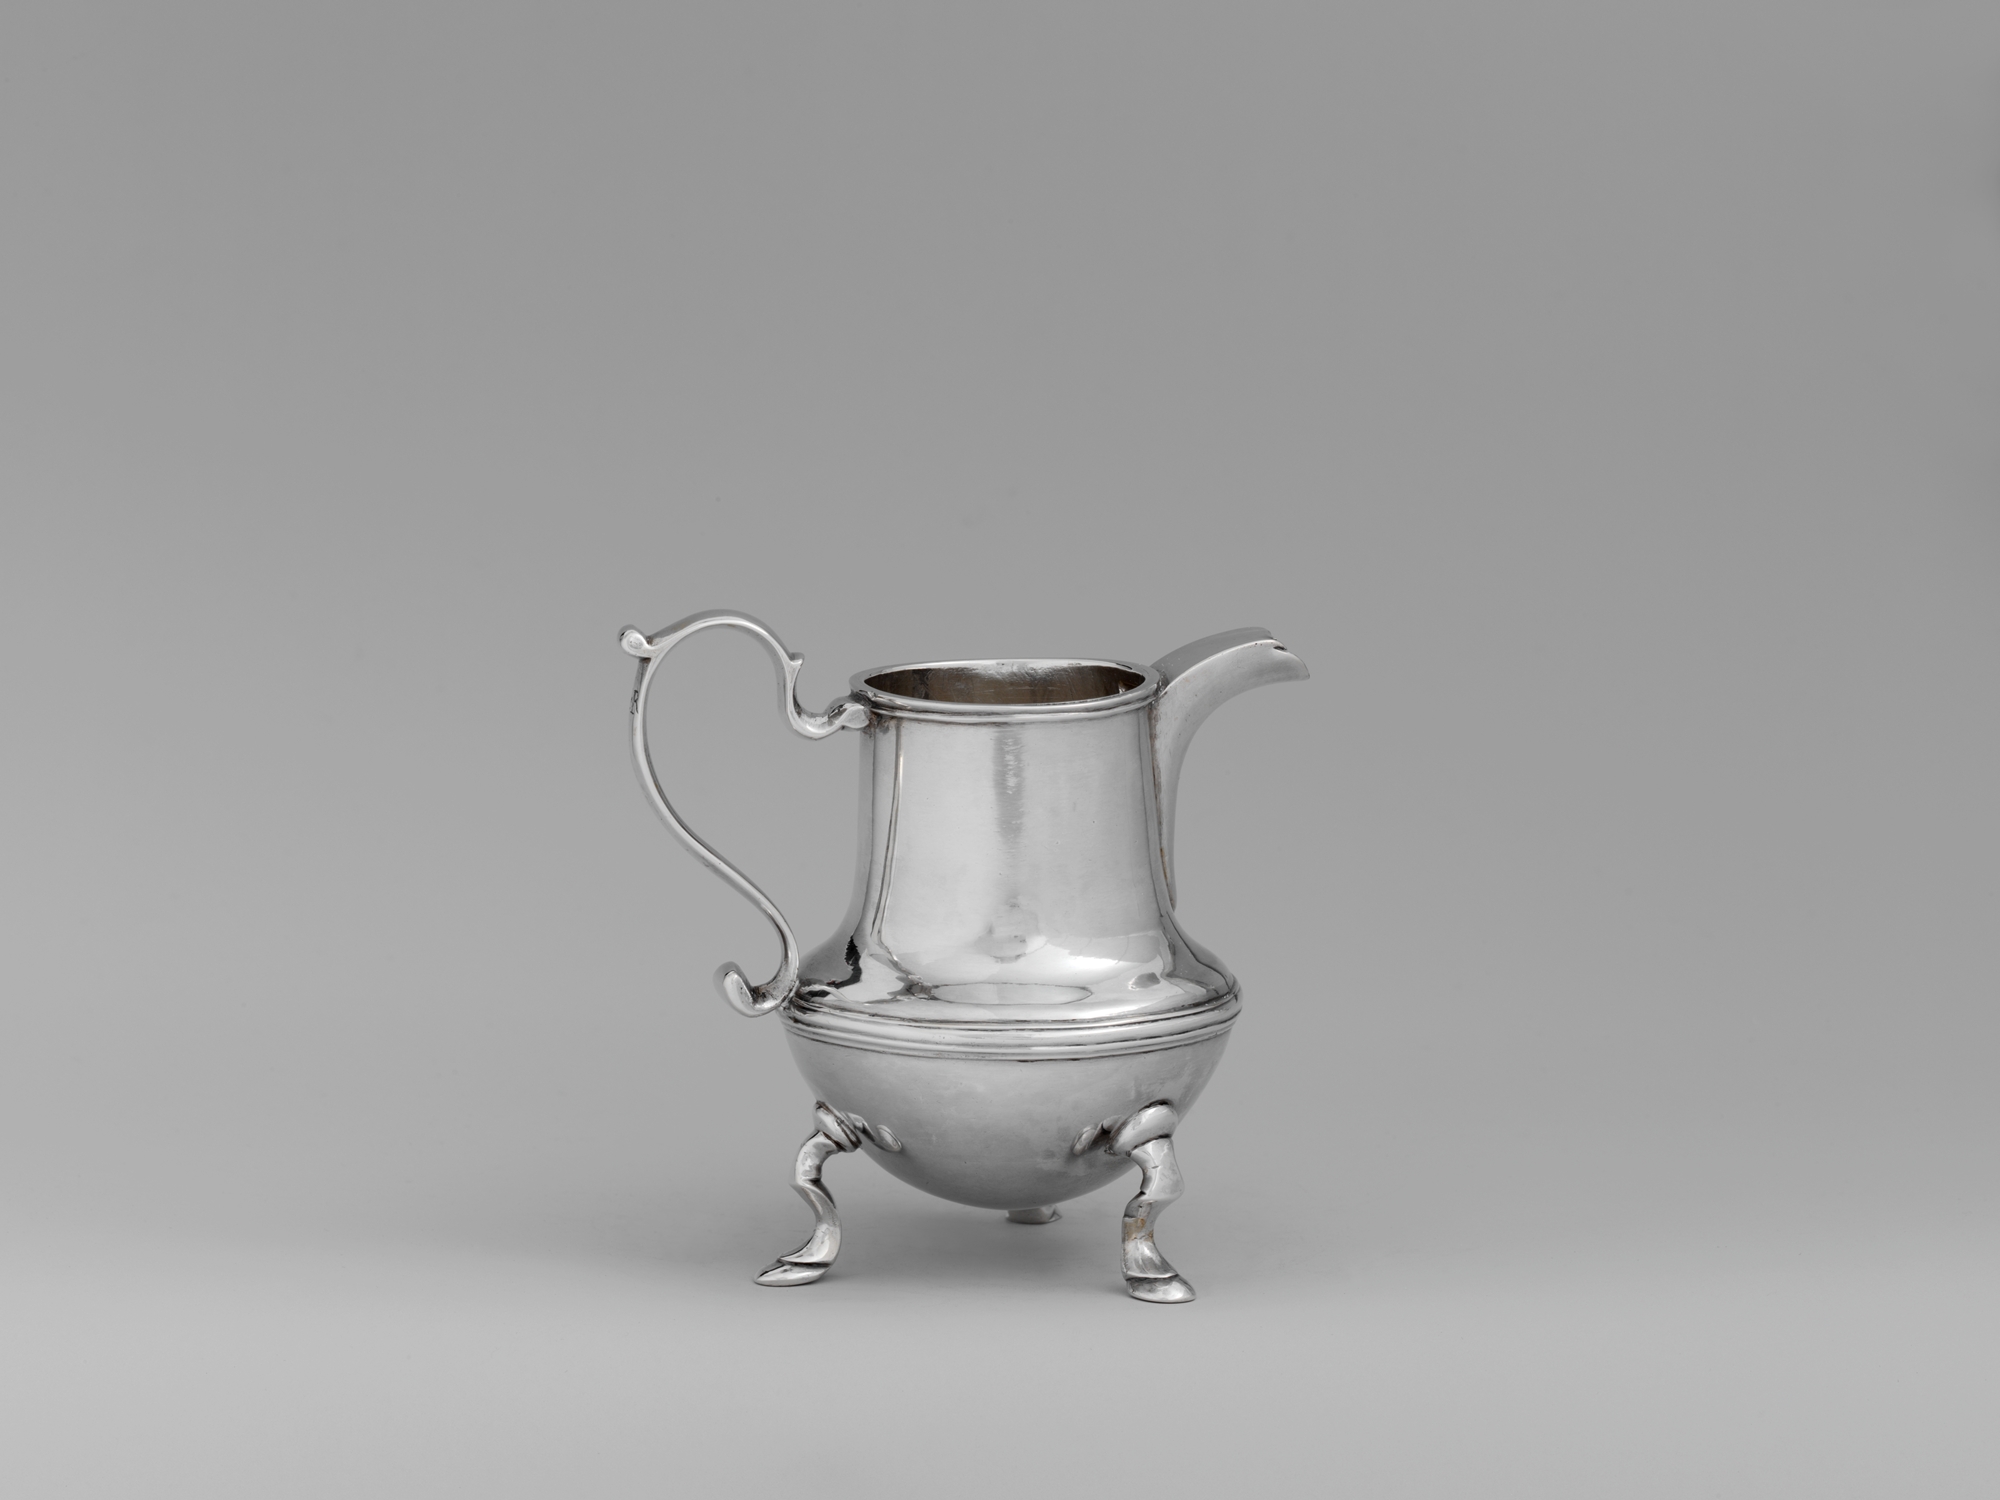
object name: cream pot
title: Creampot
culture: american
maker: adrian bancker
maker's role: maker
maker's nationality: american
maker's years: 1703-1772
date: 1730-1745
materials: silver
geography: united states